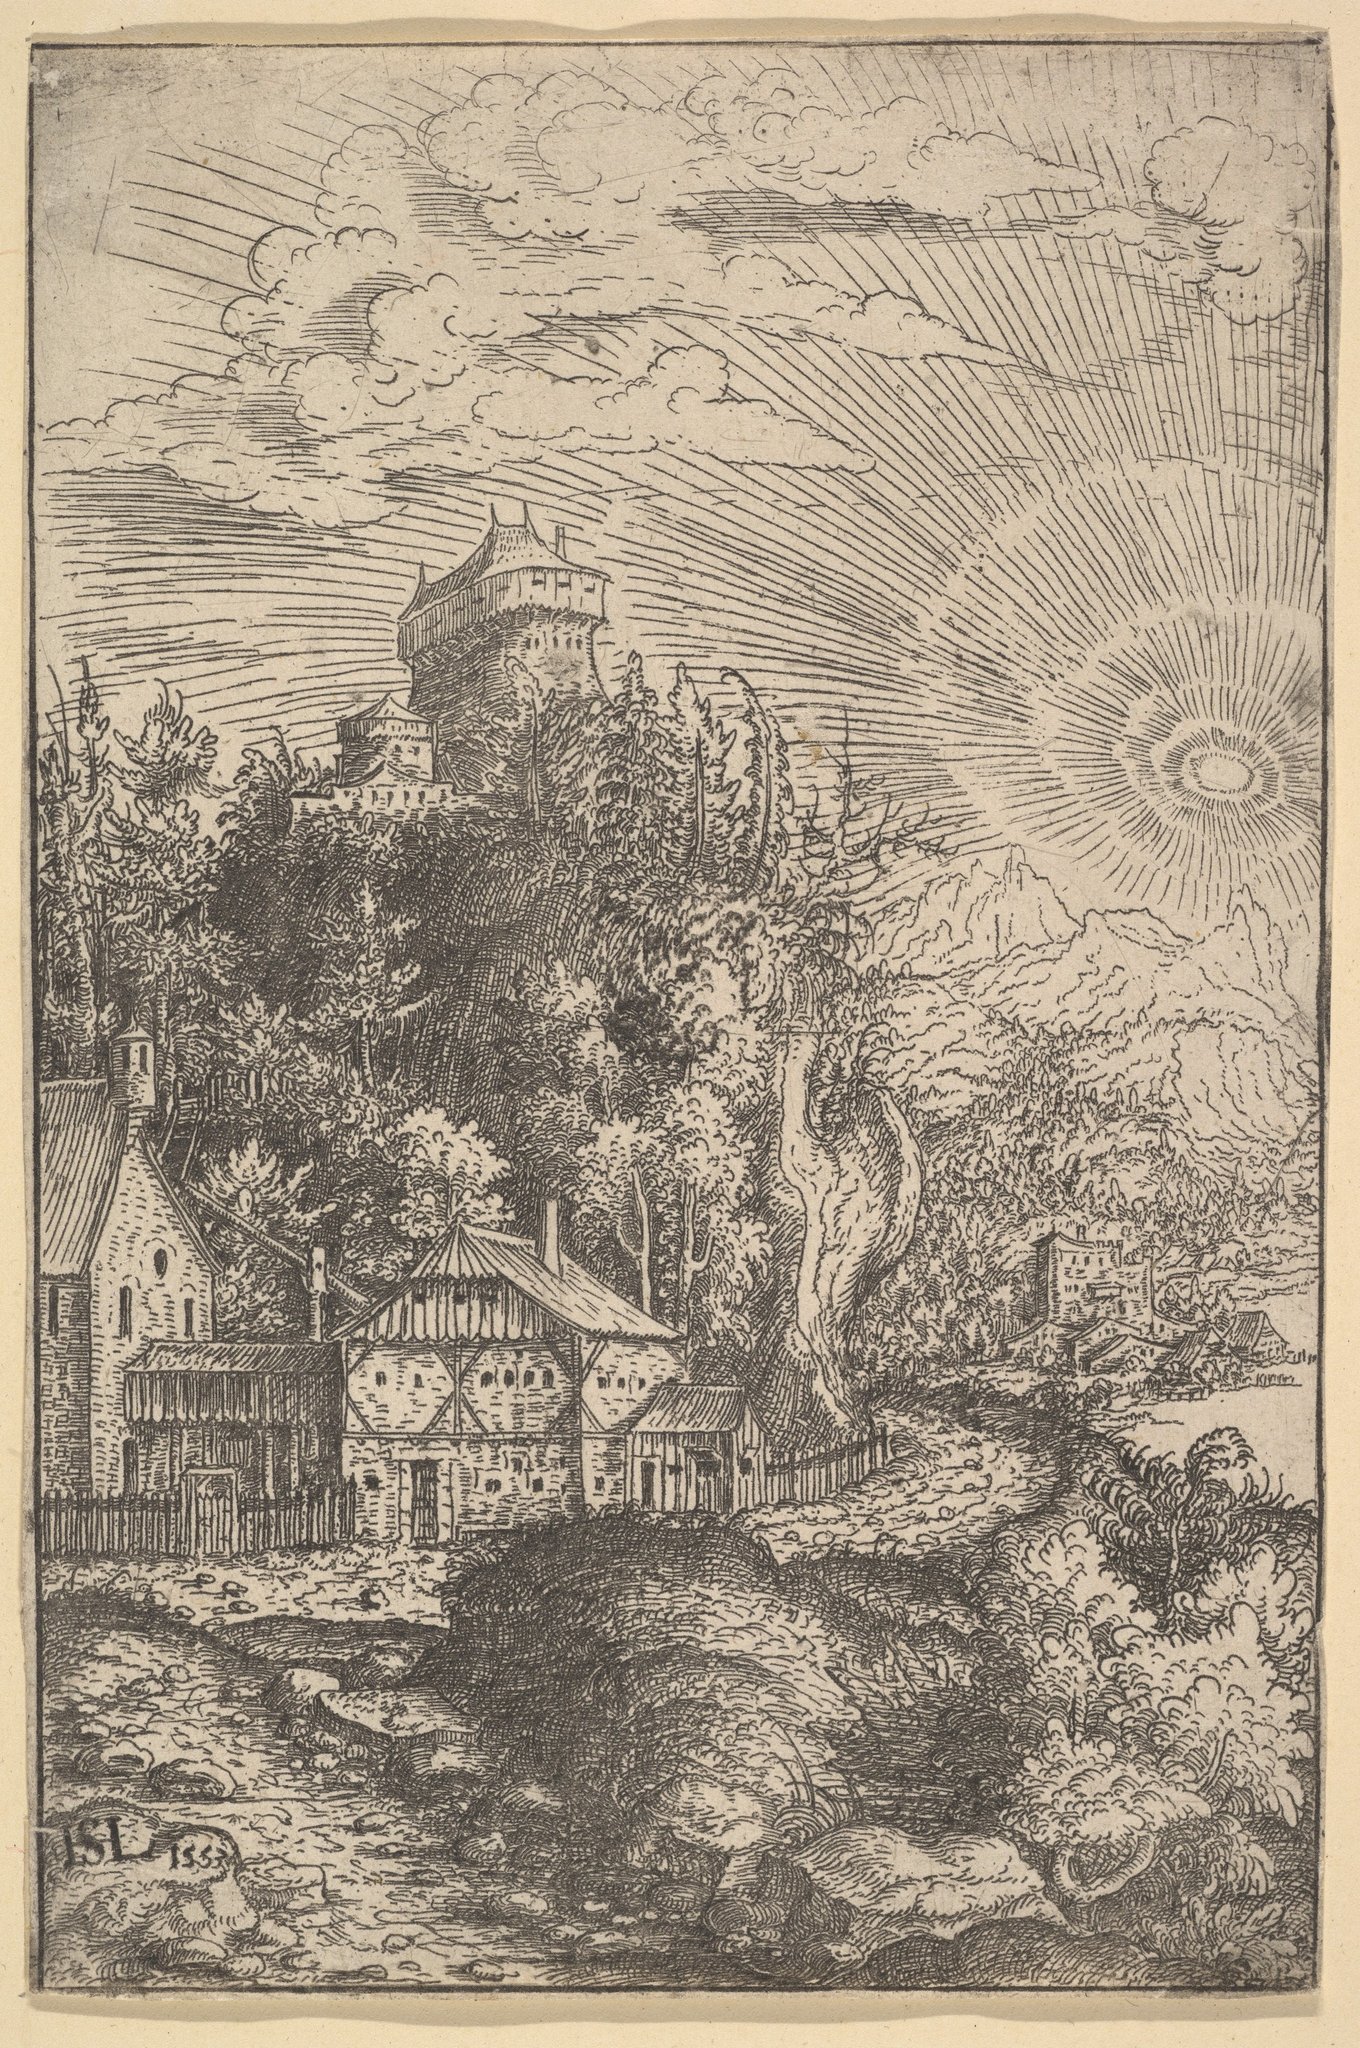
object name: print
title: Landscape with a Castle Perched on a Rock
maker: hanns lautensack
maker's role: artist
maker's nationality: german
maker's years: 1515-1566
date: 1553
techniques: etching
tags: buildings,landscapes